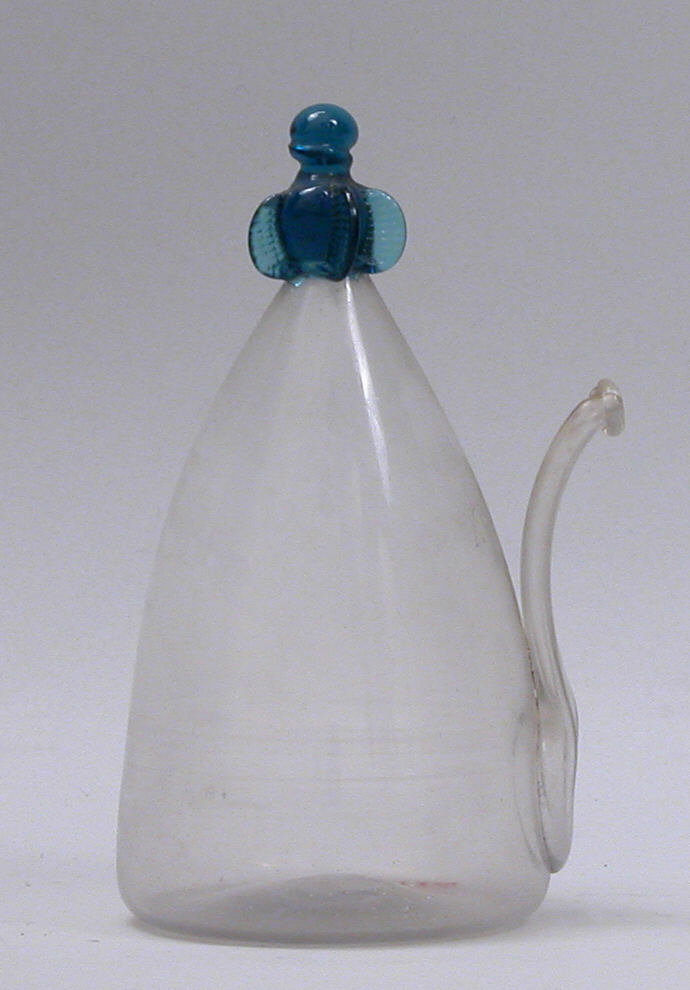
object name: bottle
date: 1701-1900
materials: glass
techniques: glassblowing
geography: iran